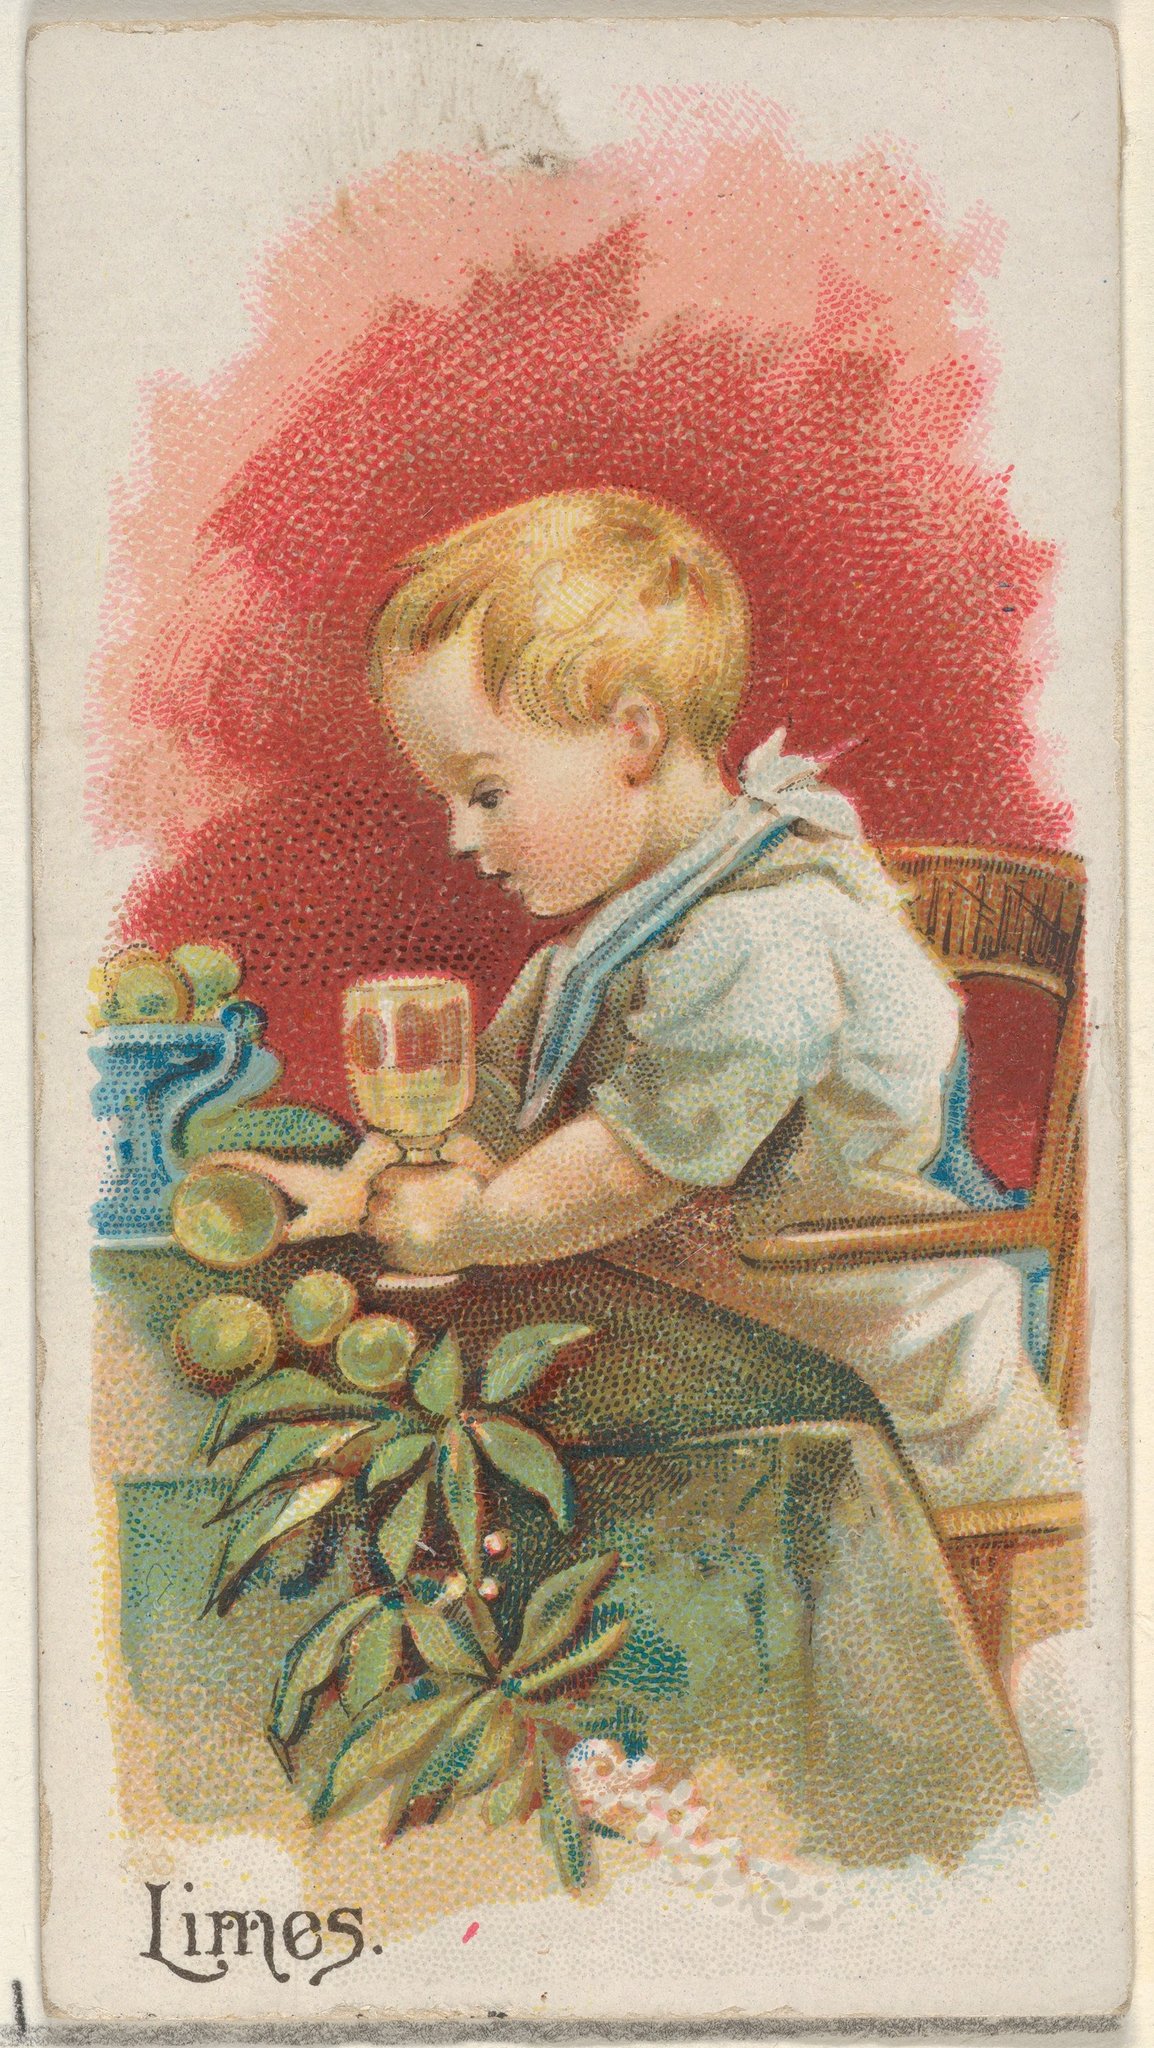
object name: print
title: Limes, from the Fruits series (N12) for Allen & Ginter Cigarettes Brands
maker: allen & ginter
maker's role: publisher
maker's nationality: american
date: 1891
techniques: color lithograph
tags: fruit,girls,profiles